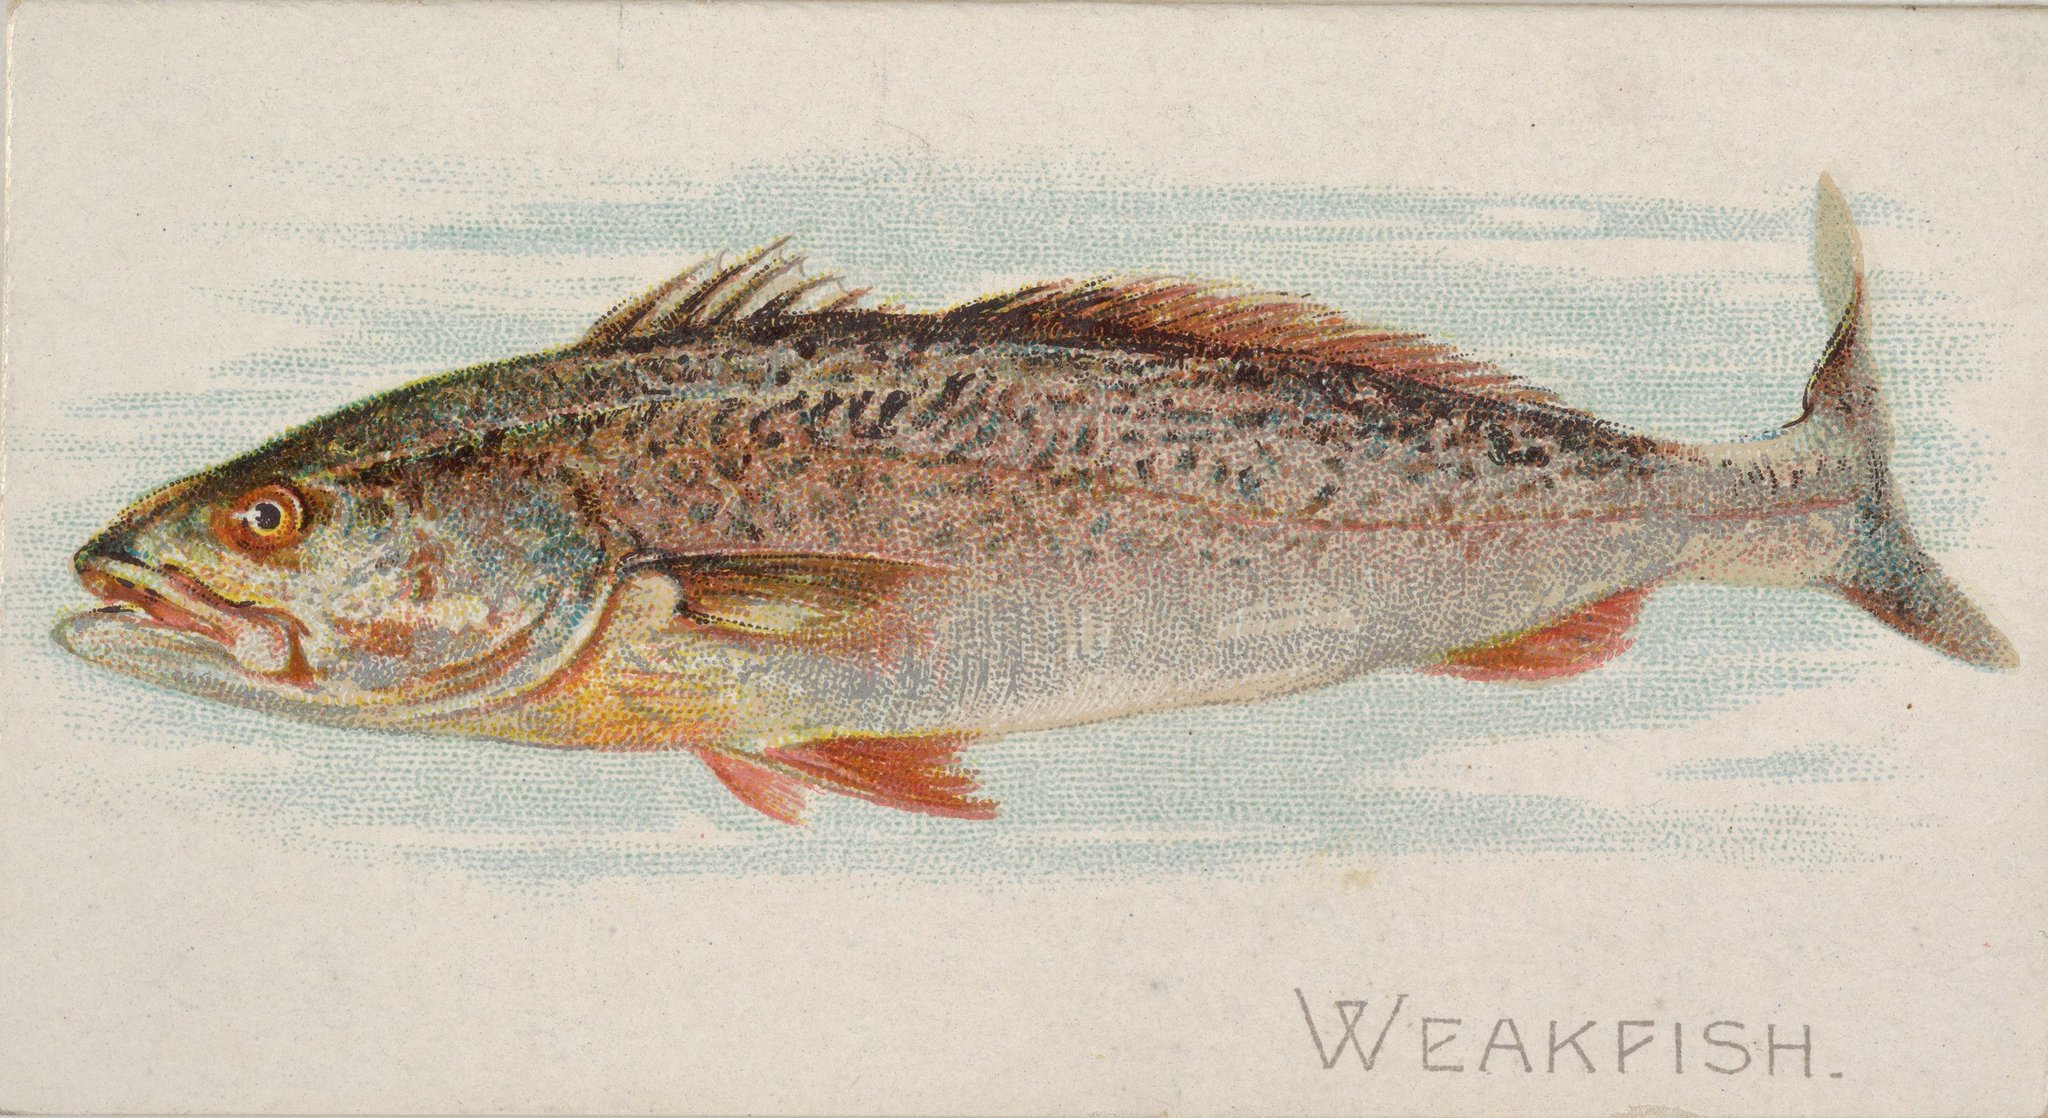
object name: print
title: Weakfish, from the Fish from American Waters series (N8) for Allen & Ginter Cigarettes Brands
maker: allen & ginter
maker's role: publisher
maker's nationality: american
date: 1889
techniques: color lithograph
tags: fish